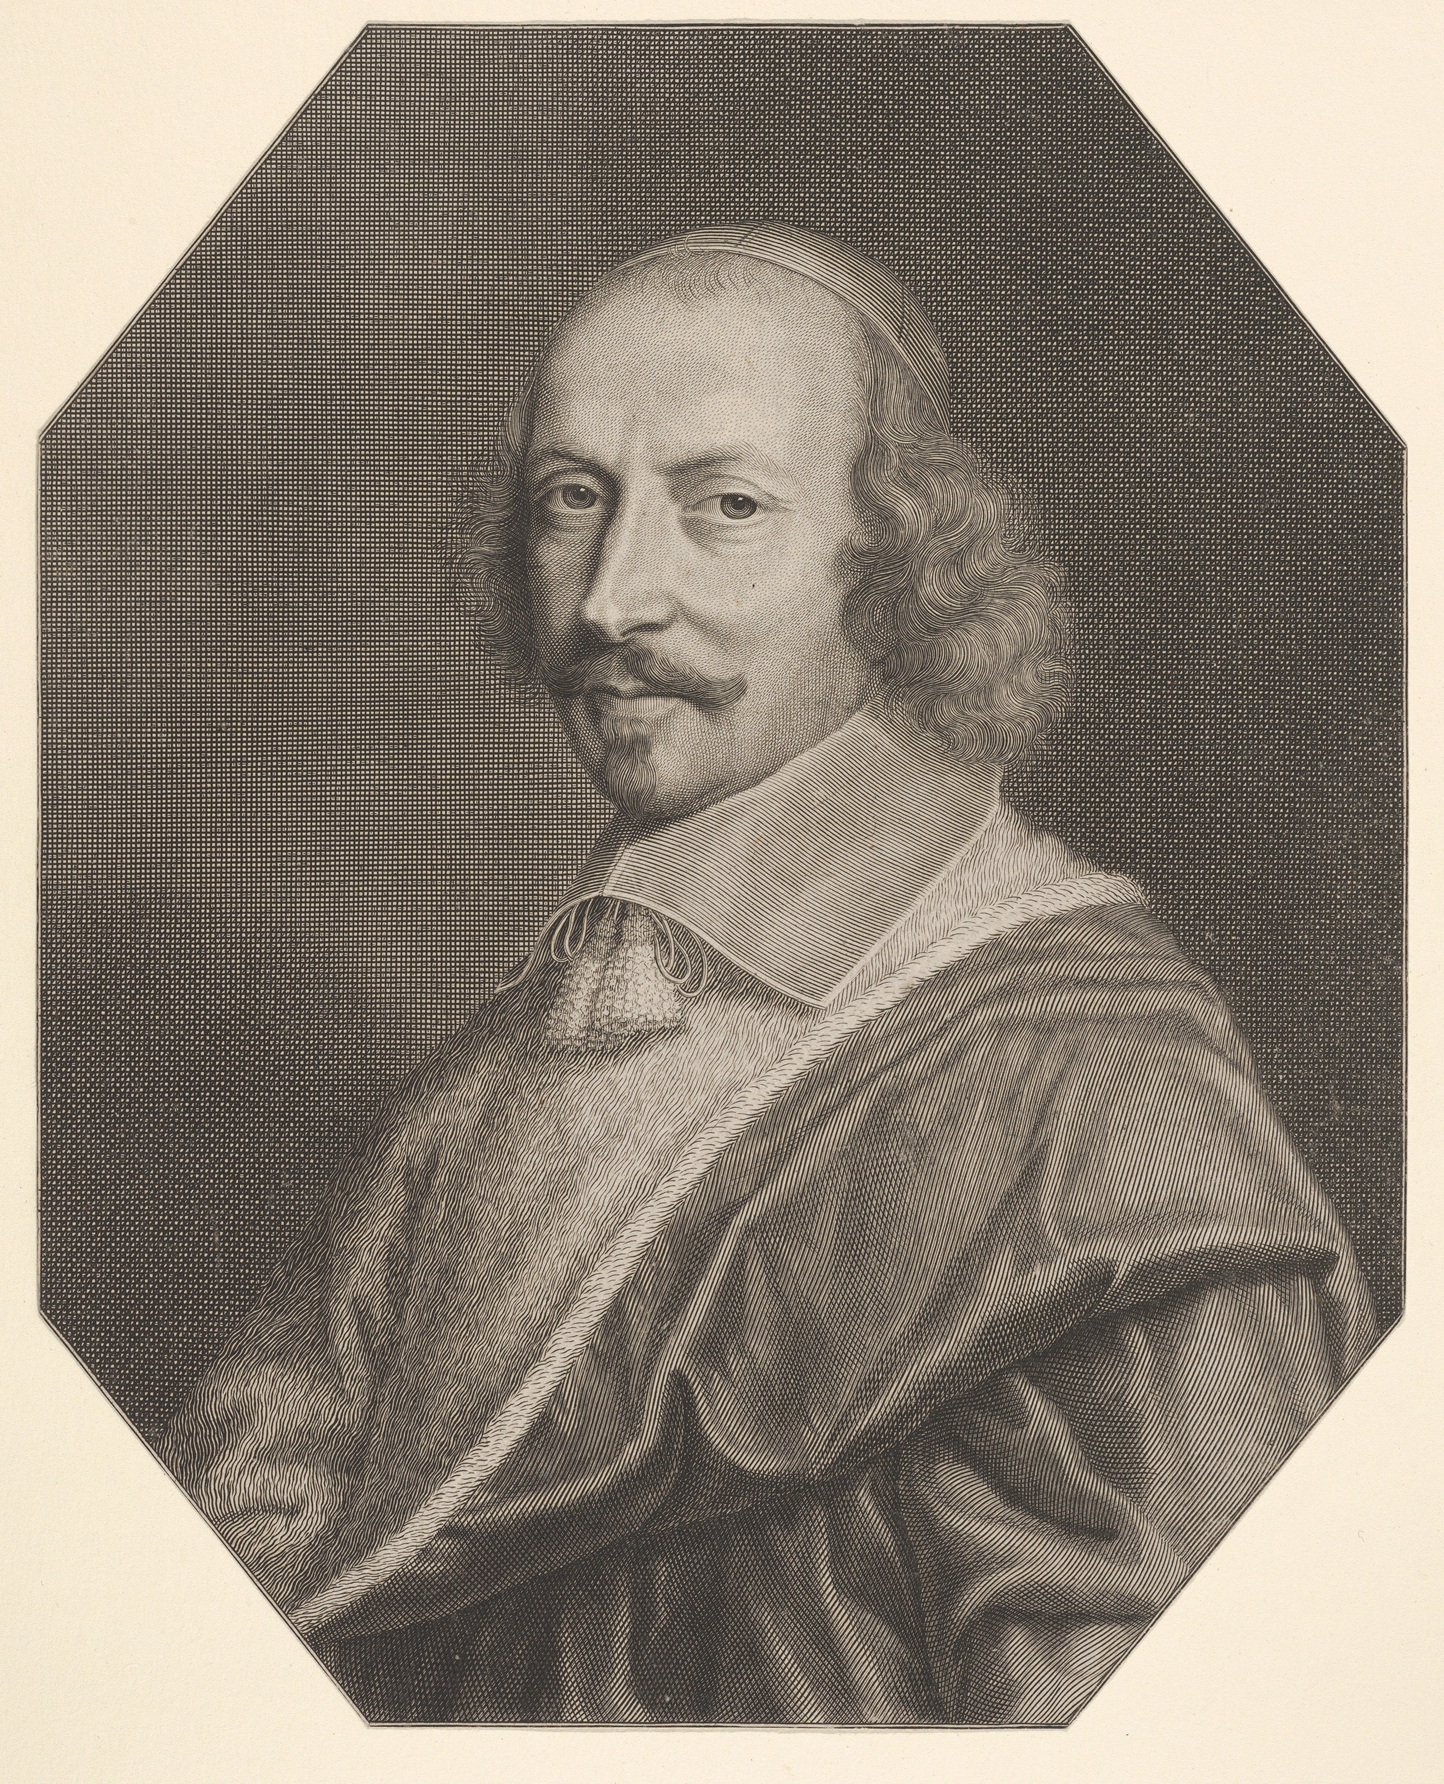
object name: print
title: Cardinal Jules Mazarin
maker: robert nanteuil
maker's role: artist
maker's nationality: french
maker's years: 1623-1678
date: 1656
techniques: engraving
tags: men,portraits